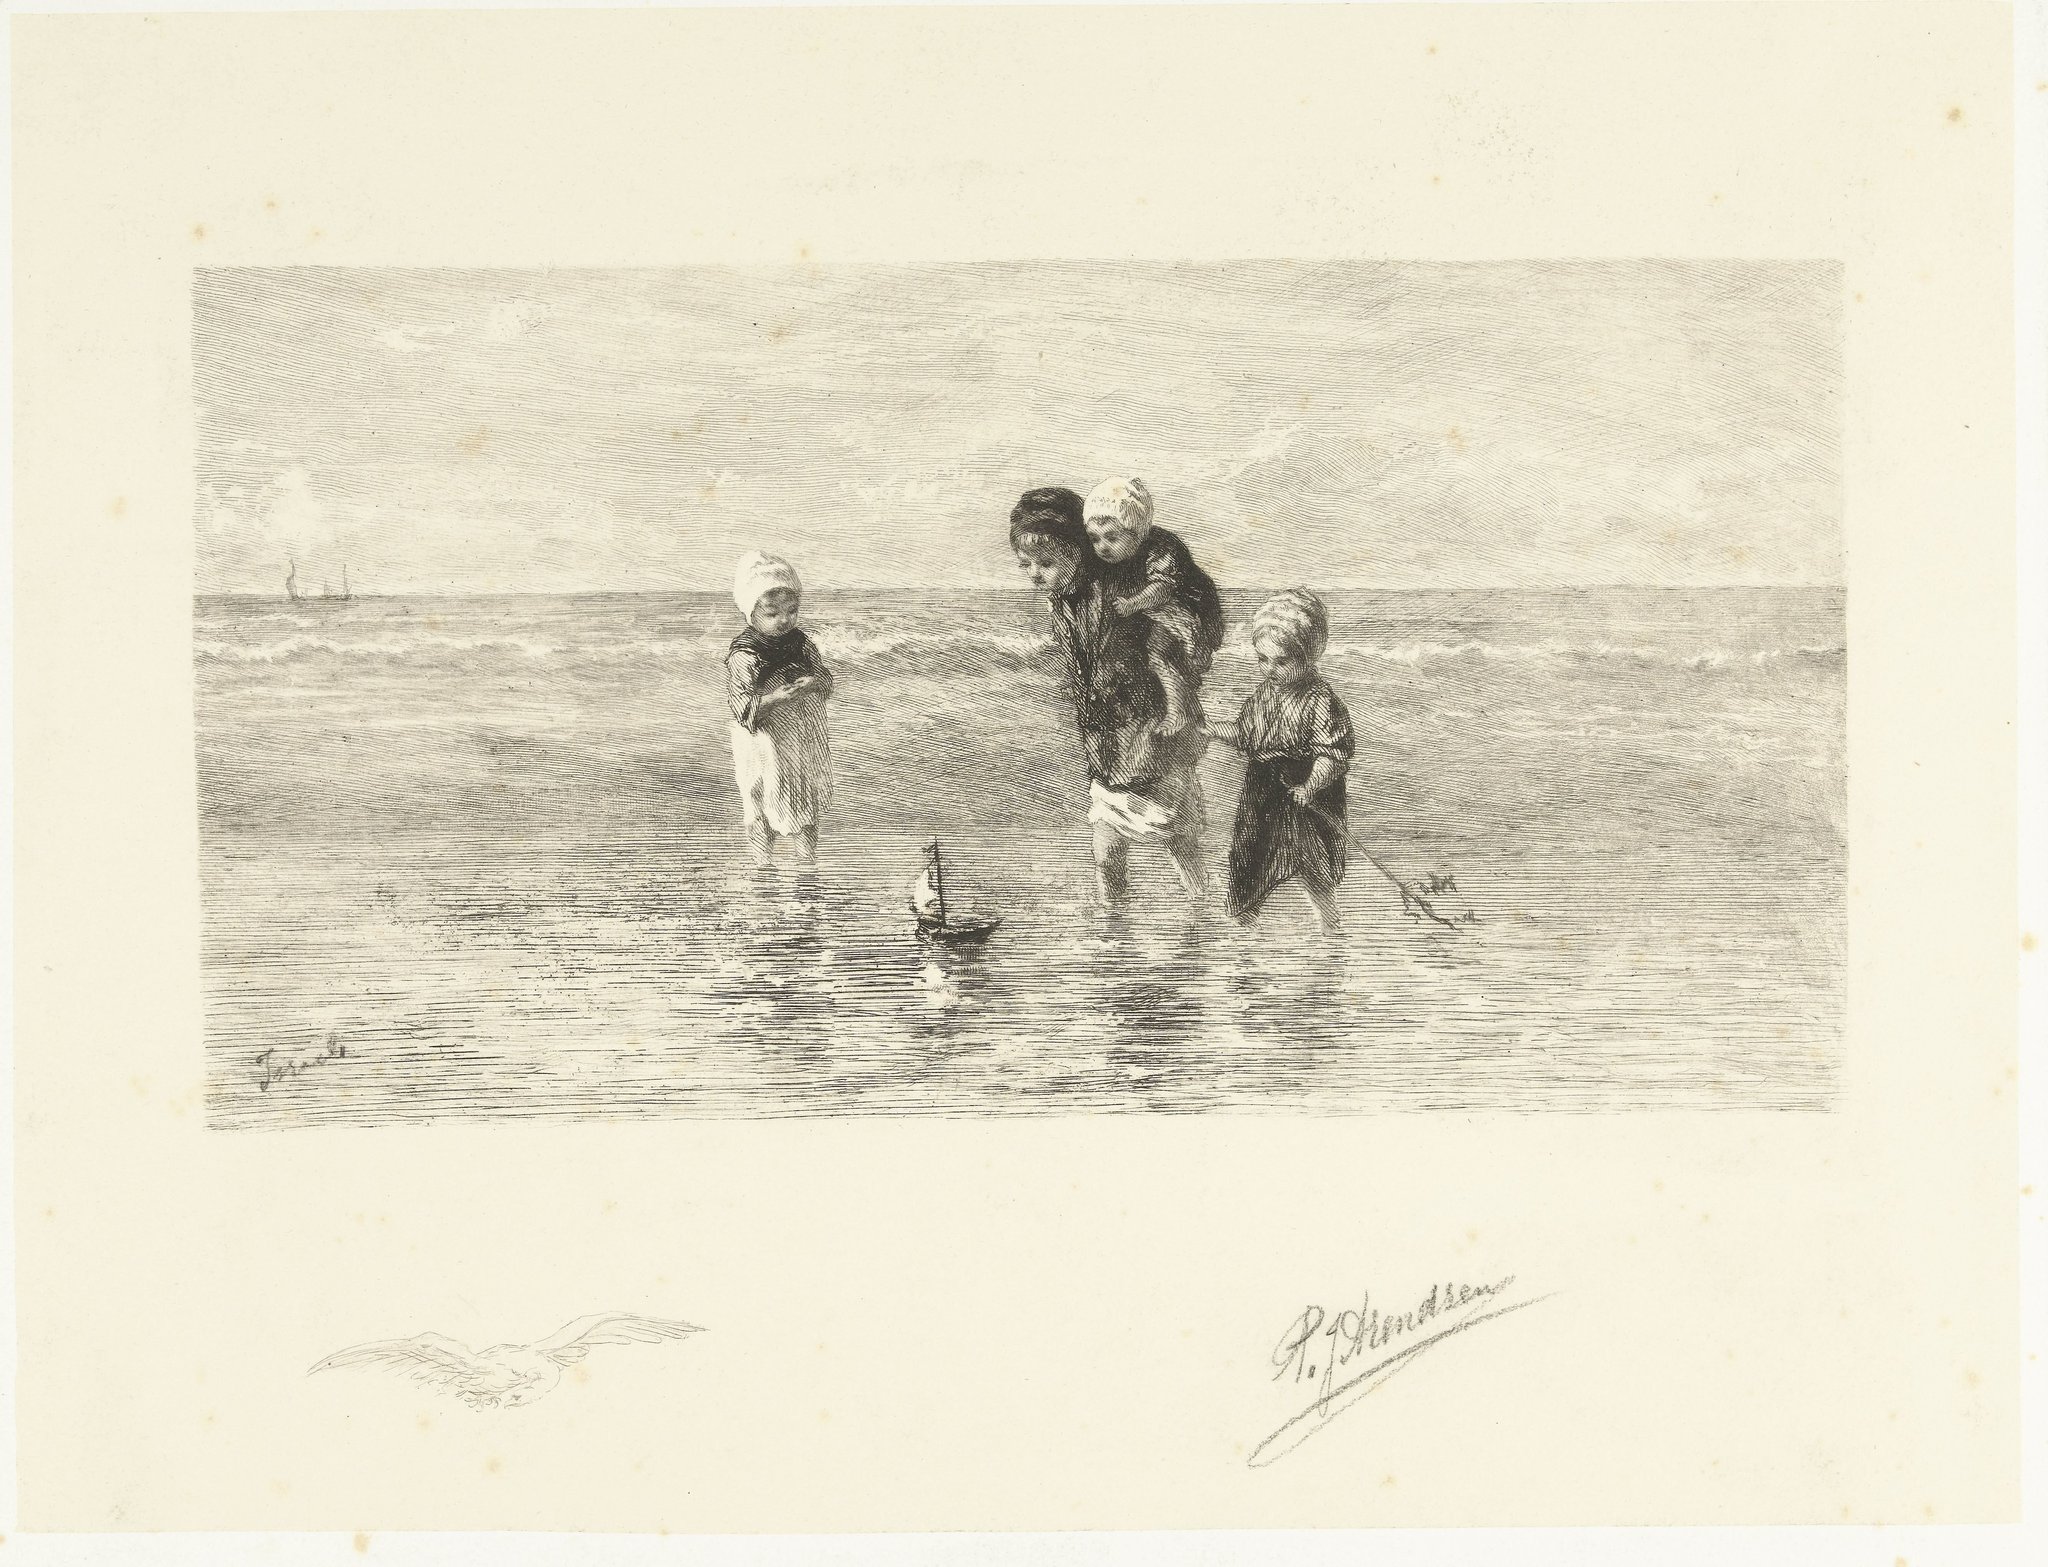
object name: print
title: Kinderen der zee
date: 1872-1909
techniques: printmaking, etching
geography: netherlands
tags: children's games and plays, sea (seascape)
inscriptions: collector's mark: Lugt 2228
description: Vier kinderen spelen met een speelgoed zeilbootje in het water aan het strand. De oudste jongen draagt een kind op zijn rug. In marge een vliegende meeuw.